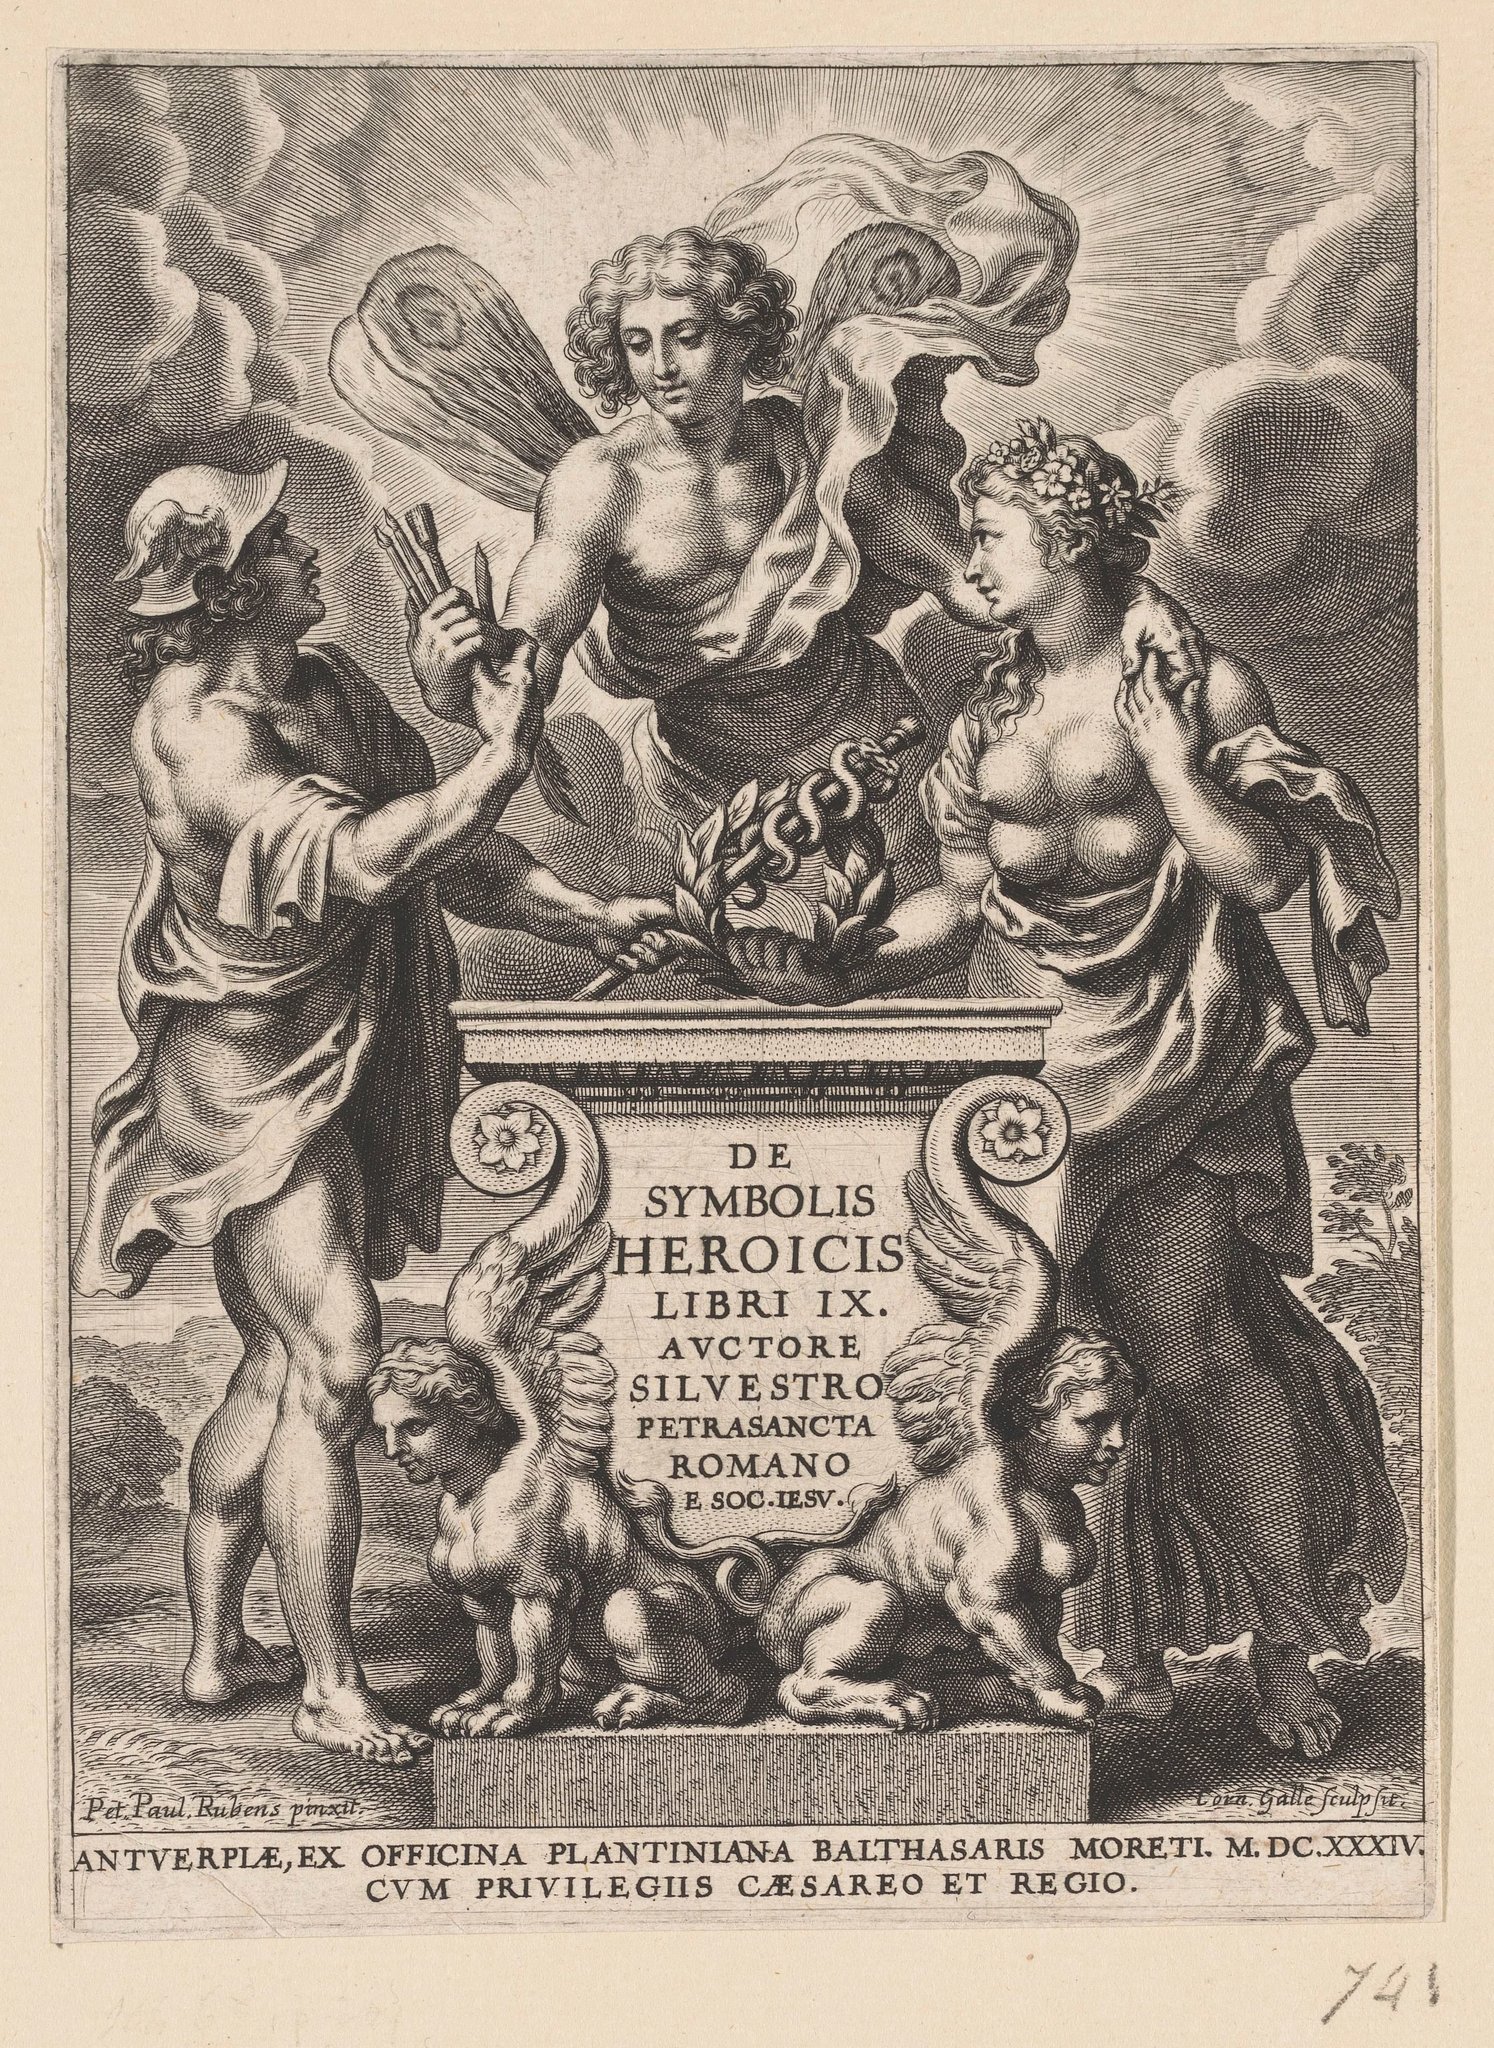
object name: titelblad, titelpagina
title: Mercurius en Natura geven hun gaven aan het Talent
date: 1634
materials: paper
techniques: engraving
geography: southern netherlands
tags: 'natura' (allegorical figure or scene; or as diana of ephesus, with many breasts); 'natura' (ripa), (story of) mercury (hermes), talent (+ personification)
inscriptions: collector's mark: Lugt 240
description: Om een altaar staan drie figuren. Mercurius, als vertegenwoordiger van de Kunsten, geeft penselen aan een gevleugelde geni die achter het altaar staat. Rechts staat de personificatie van de Natuur, een vrouw met meerdere borsten en een bloemenkrans. Ze houdt de hand van de gevleugelde figuur vast. De gevleugelde man staat voor het Talent dat kan putten uit de kunsten en de natuur.